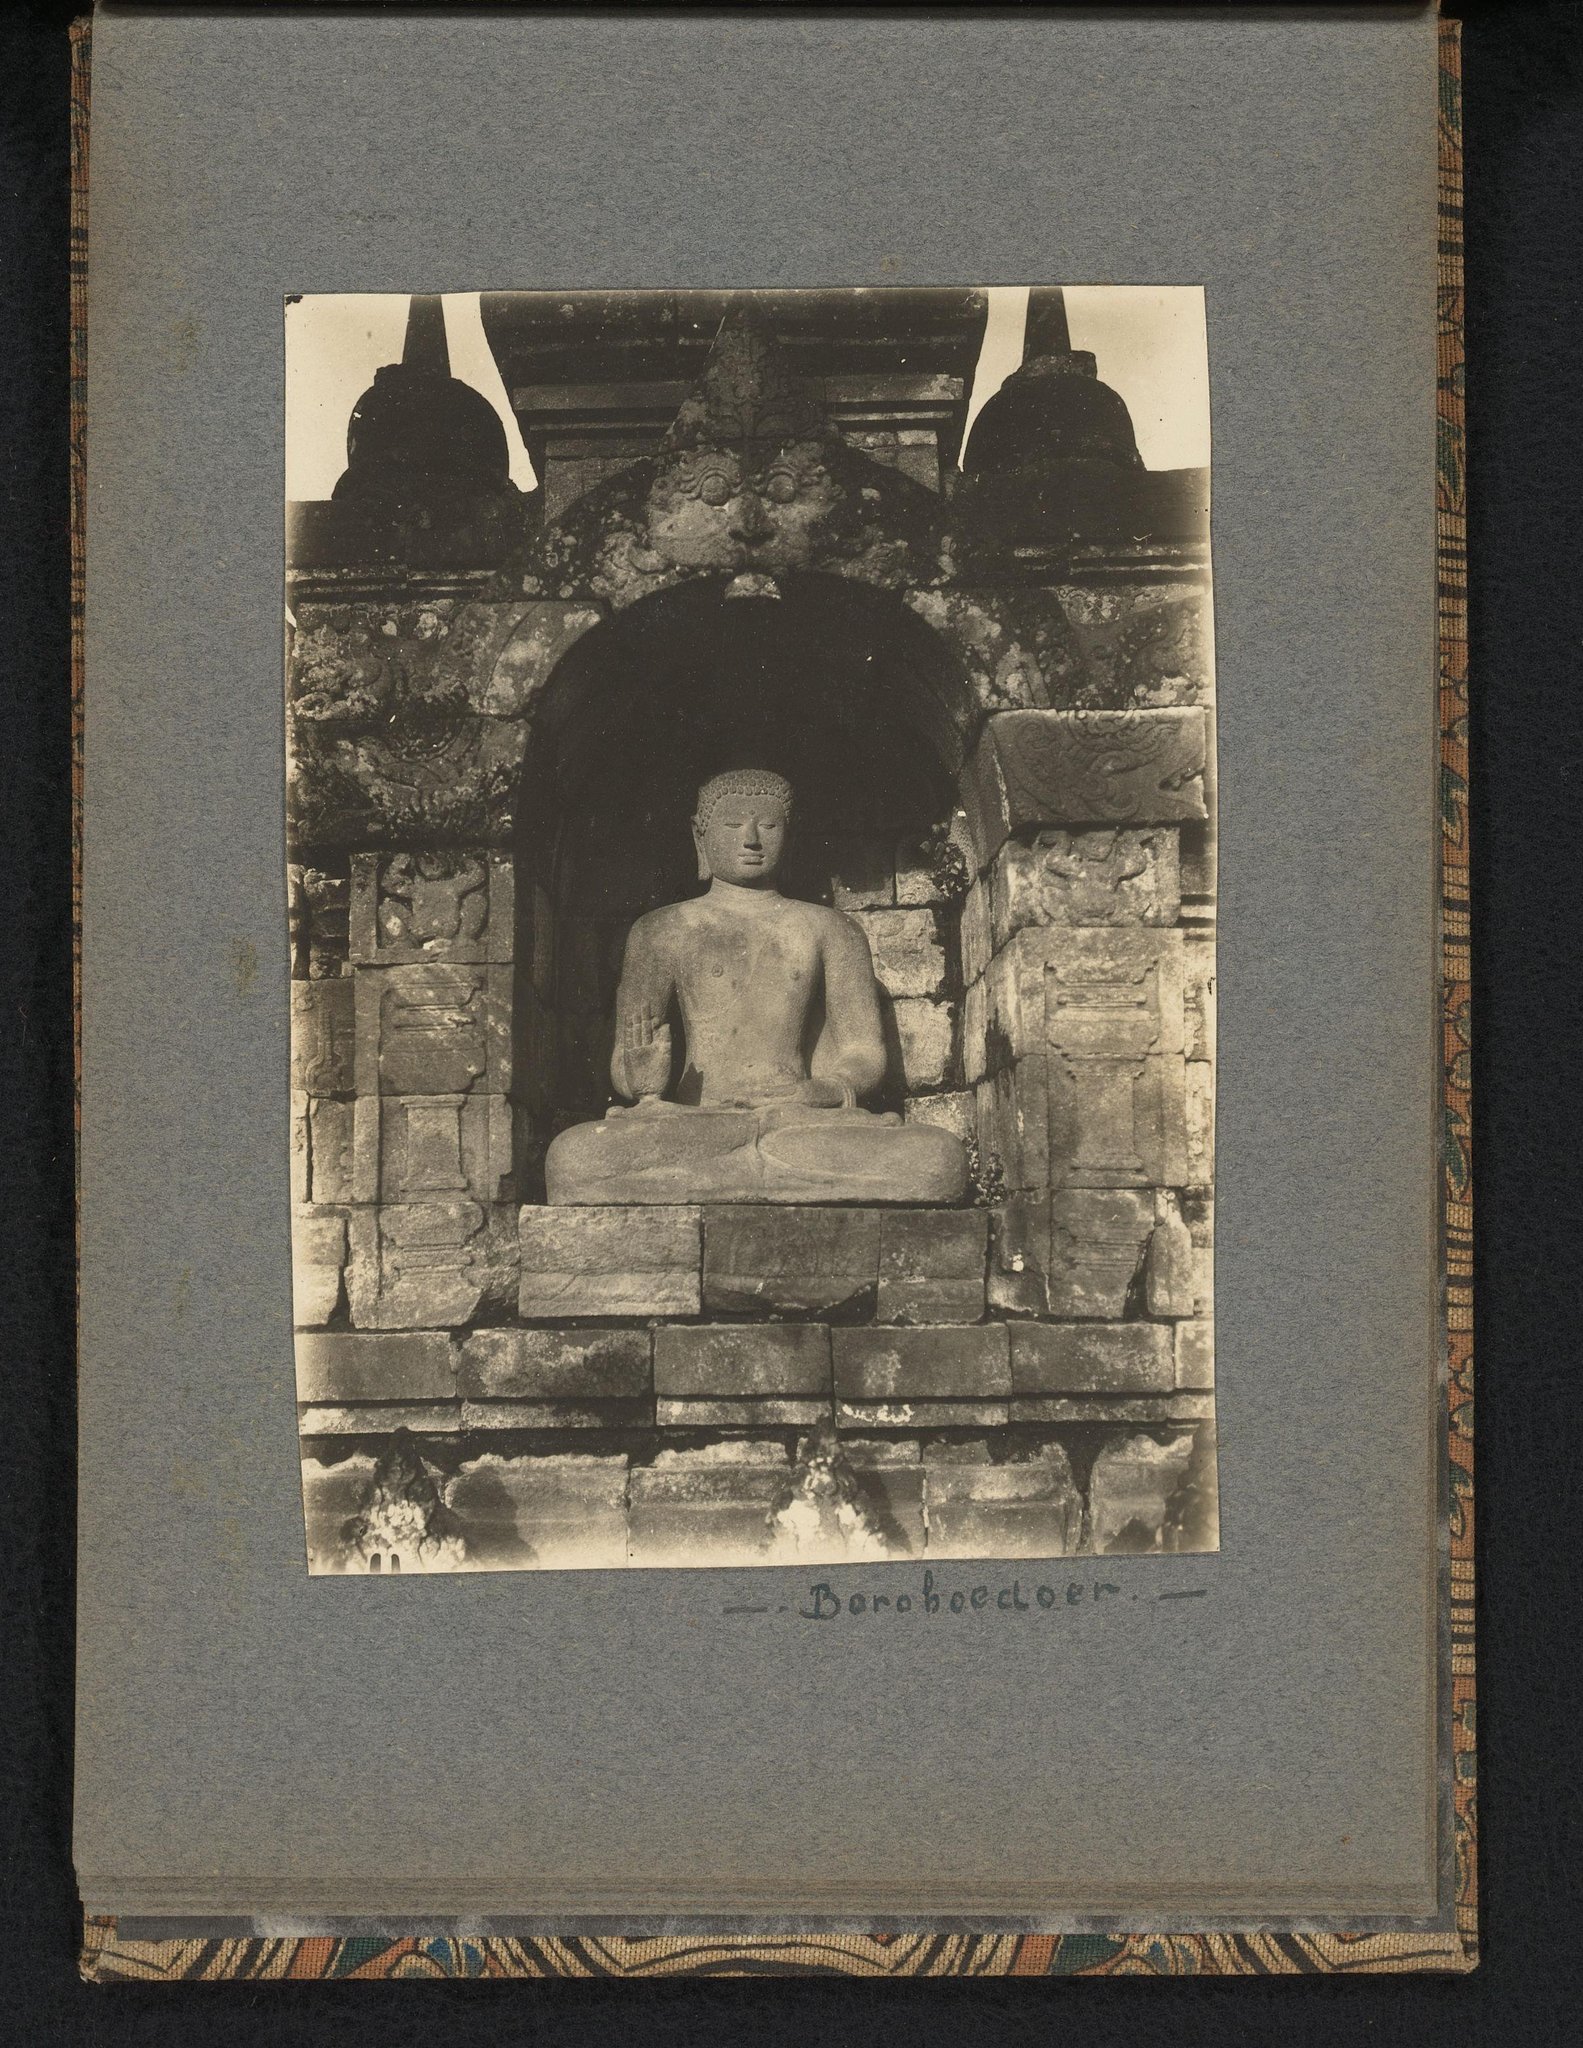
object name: photograph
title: Boeddhabeeld op de Borobudur in Midden-Java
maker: karel frederik van den berg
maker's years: 1873-1948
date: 1921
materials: paper, cardboard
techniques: gelatin silver print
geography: central java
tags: temple, shrine ~ hinduism, buddhism, jainism